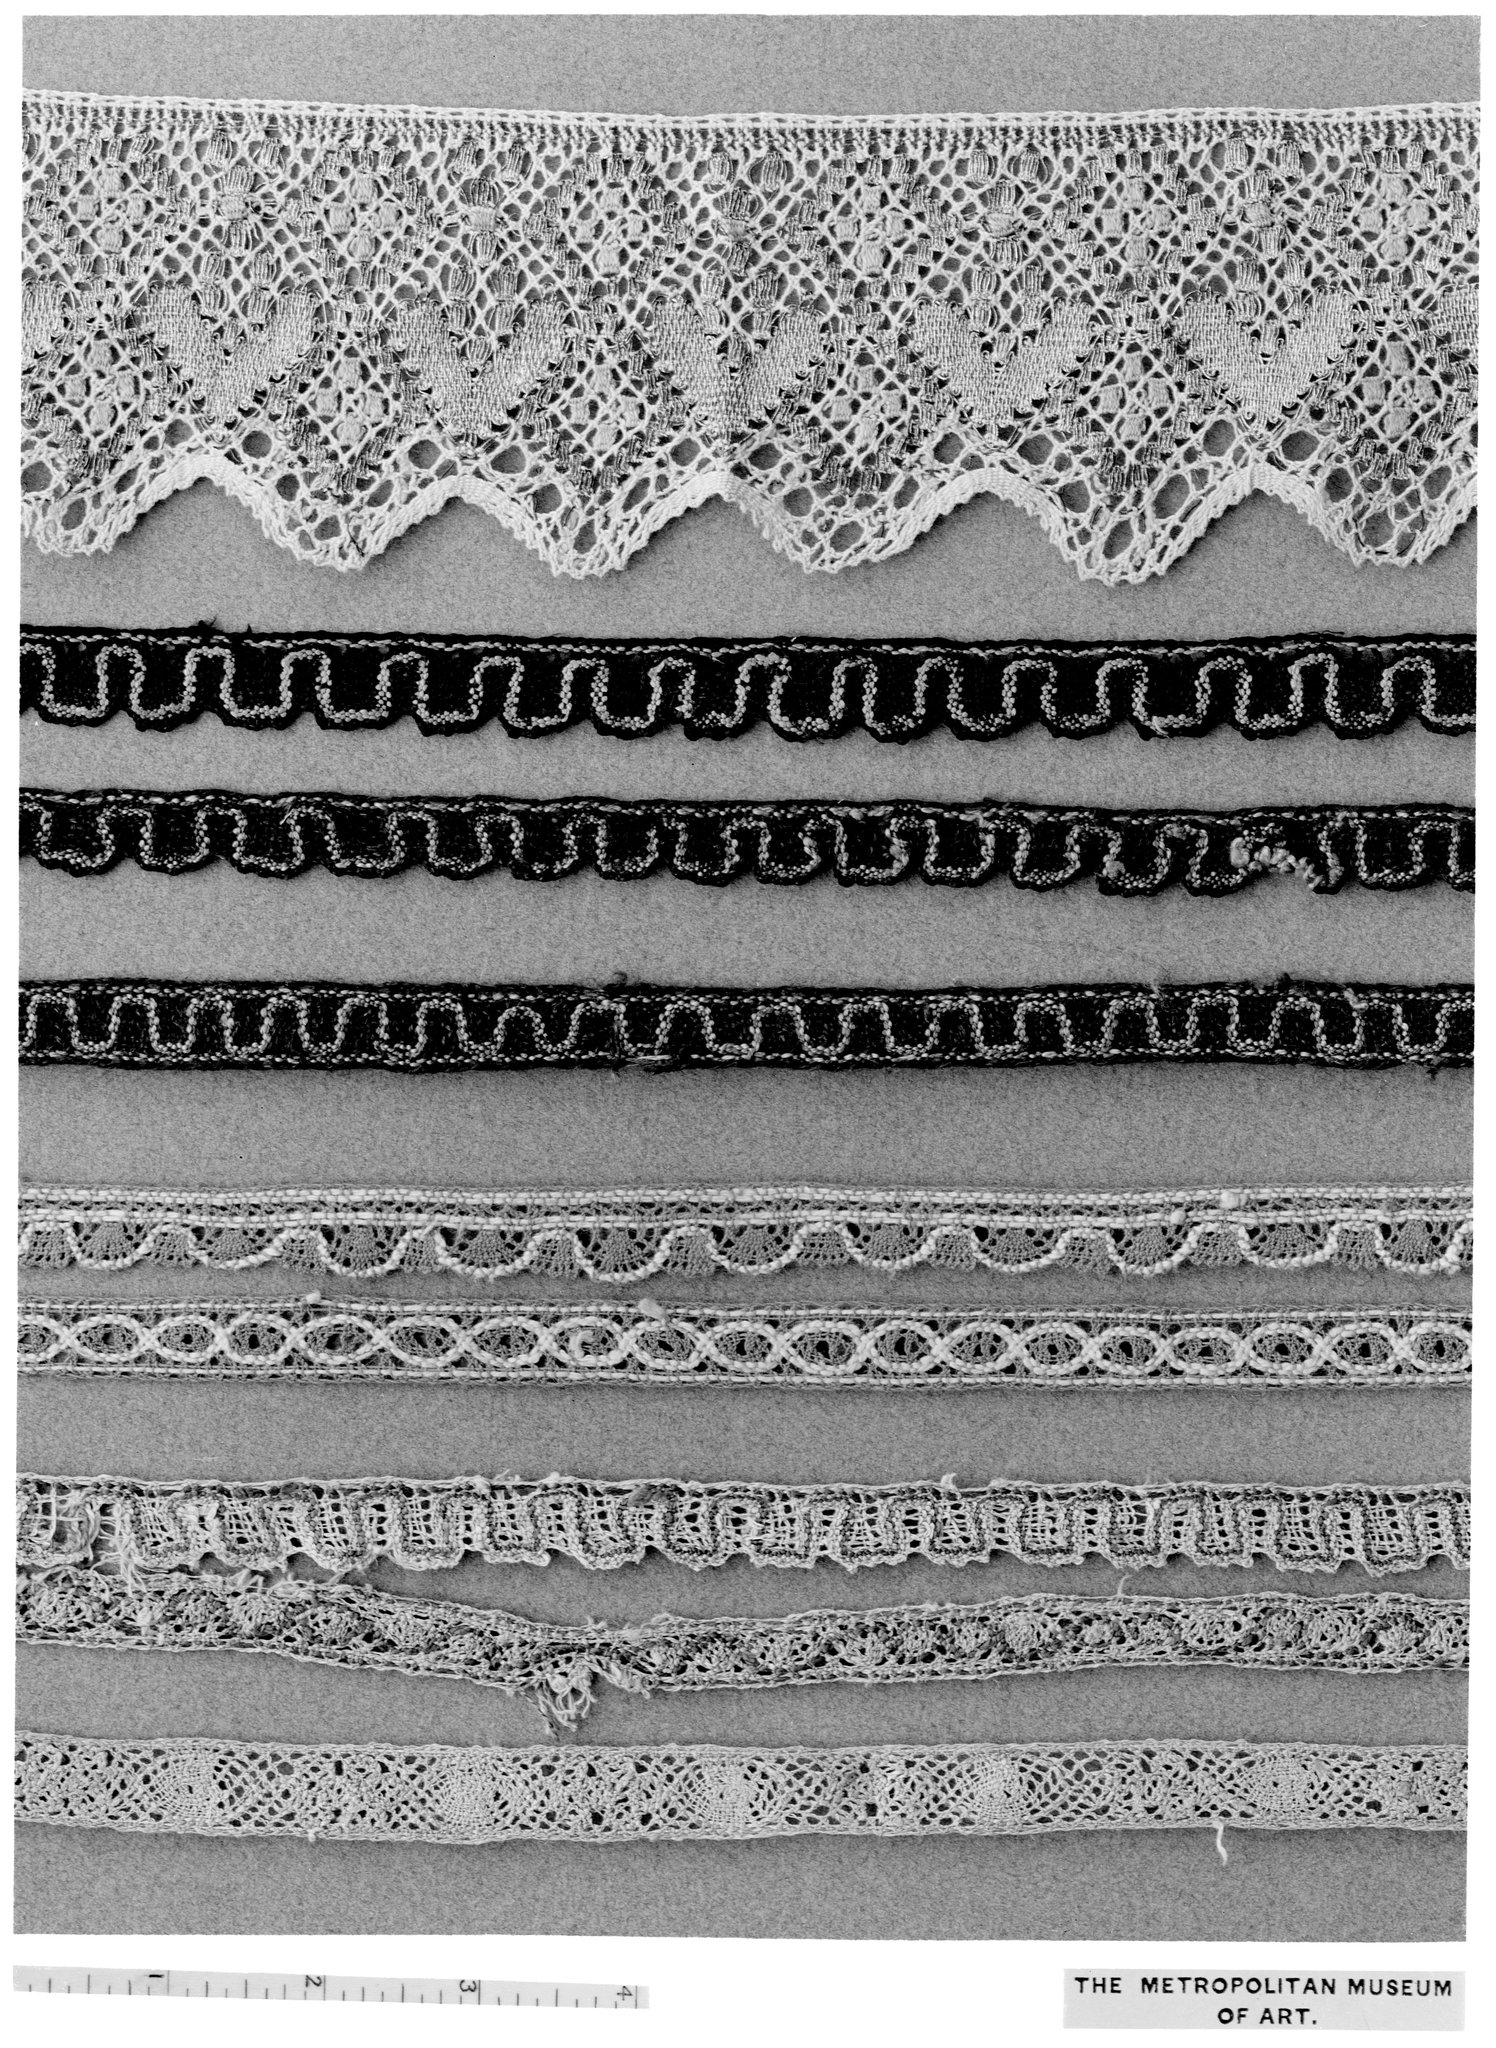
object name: insertion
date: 1801-1900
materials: cotton, silk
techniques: lace